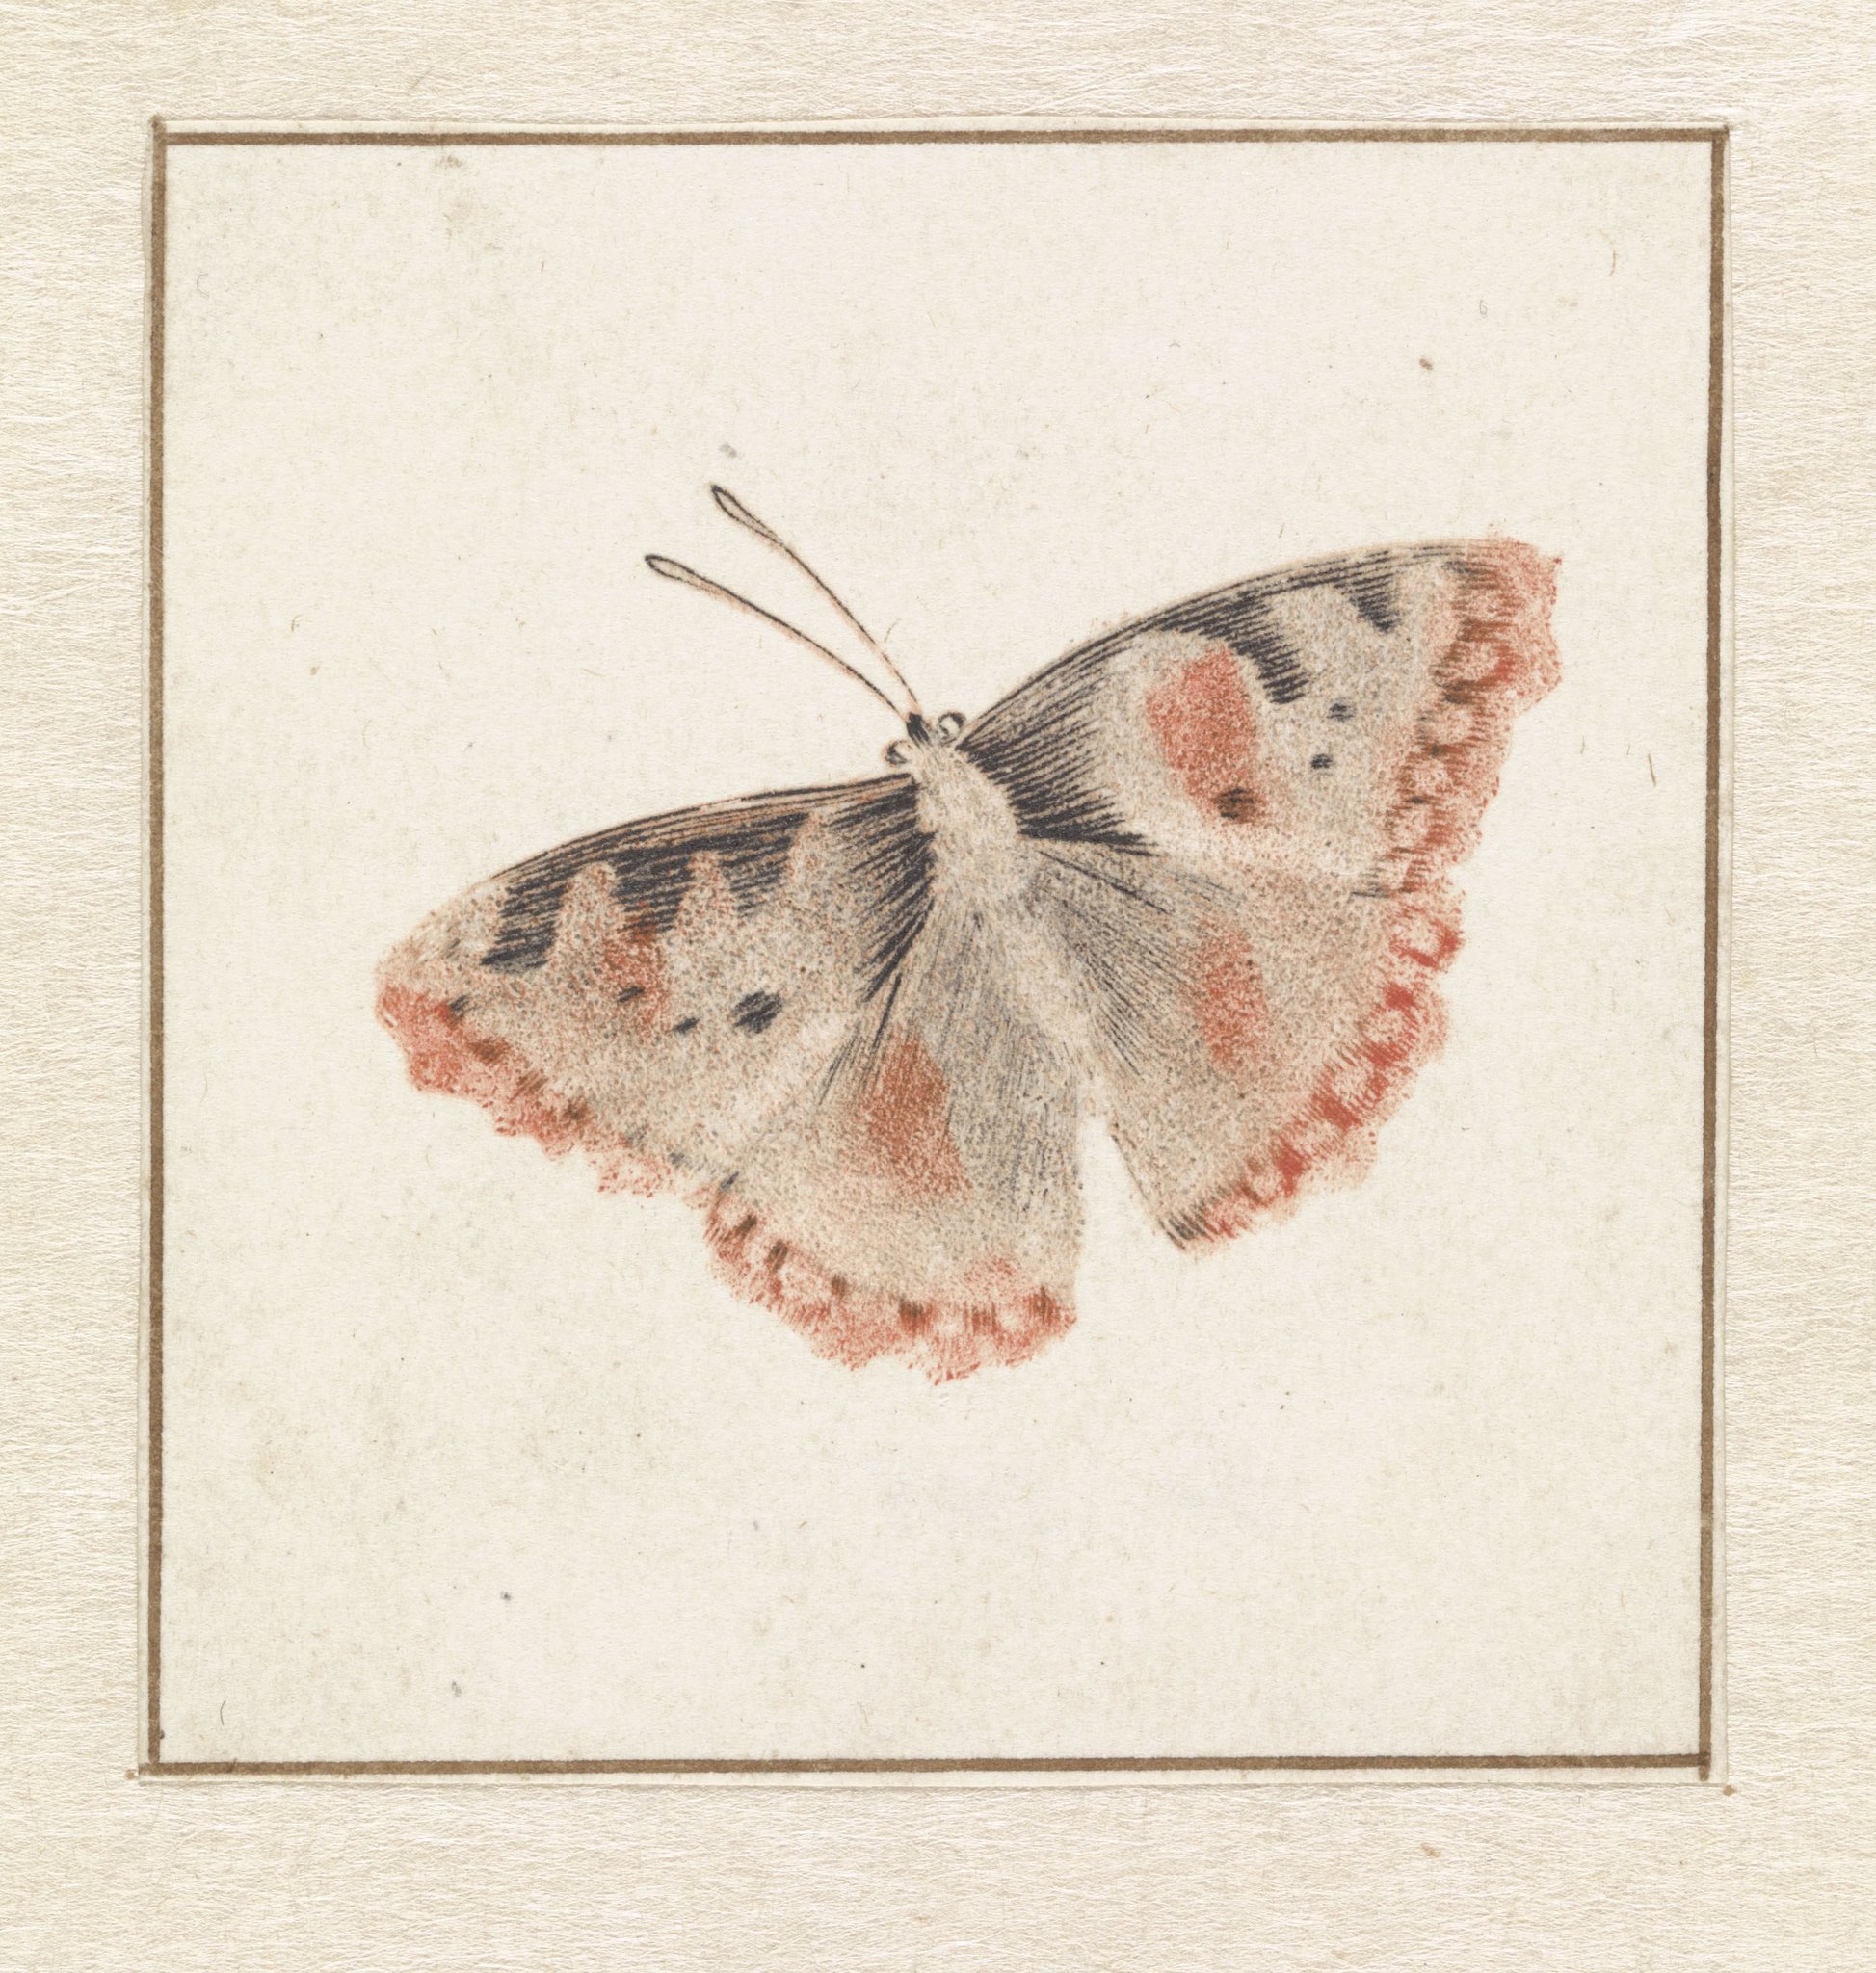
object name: print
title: Vlinder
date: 1688-1698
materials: paper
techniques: printing, engraving, lithography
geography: netherlands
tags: insects: butterfly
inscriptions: collector's mark: Lugt 2228